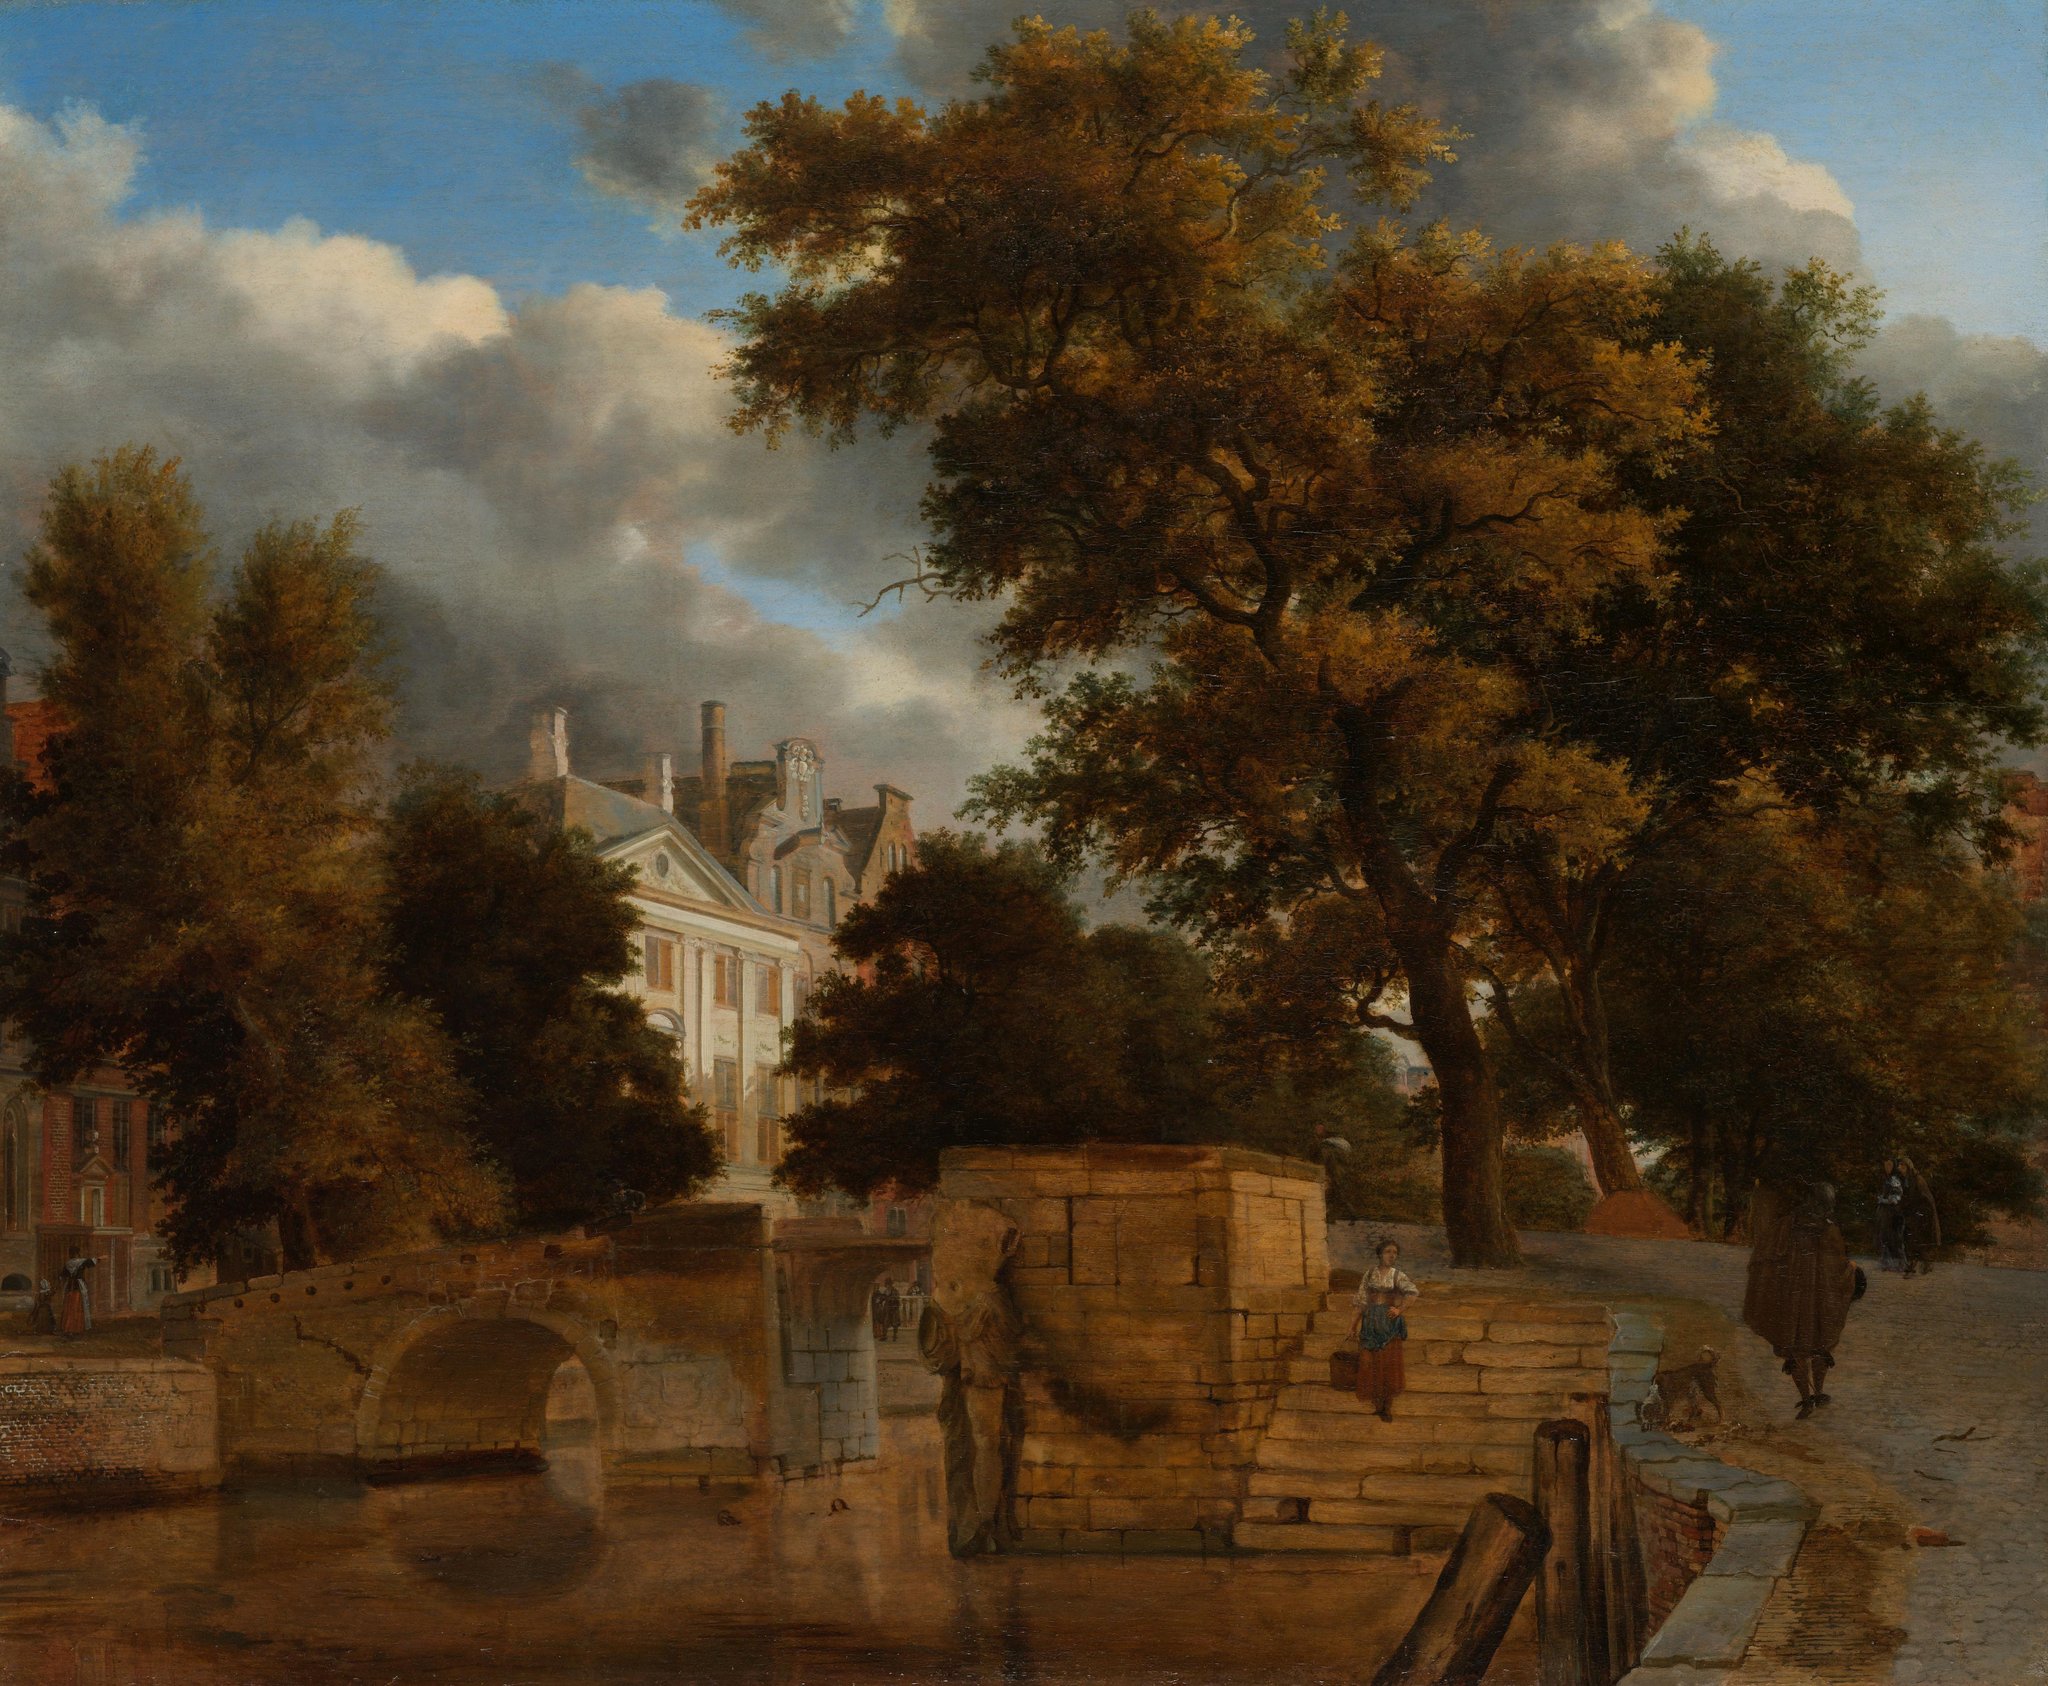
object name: painting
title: The Stone Bridge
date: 1660-1672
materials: oil, panel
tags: bridge in city across river, canal, etc.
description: This work depicts an imaginary canal. While it is clearly inspired by Amsterdam models, Jan van der Heyden gave it his own twist. A striking aspect is the way he rendered the canal, which runs from the foreground to the centre of the composition. Adriaen van der Velde painted the figures, which he was regularly asked to do by other artists as well.